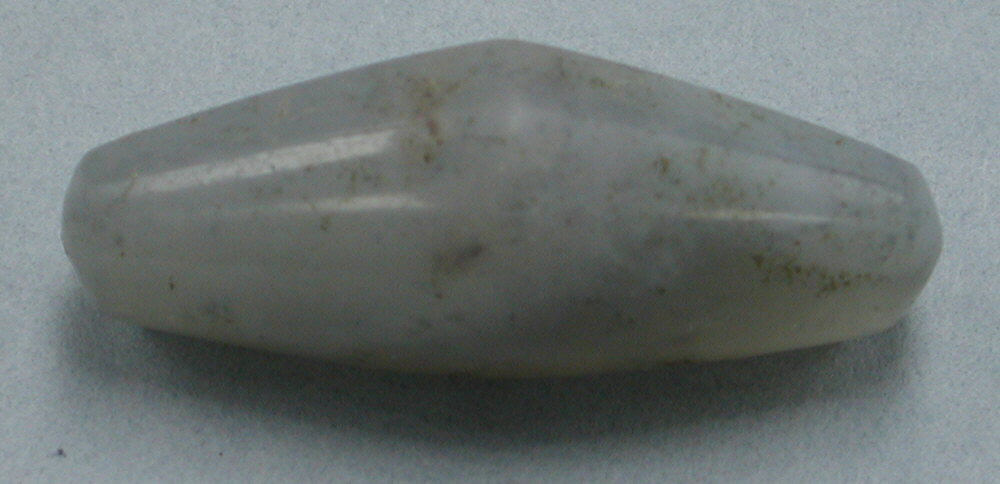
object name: ritual stone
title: Polishing Stone (pulidor)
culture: mexican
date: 1501-1600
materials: stone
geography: mexico